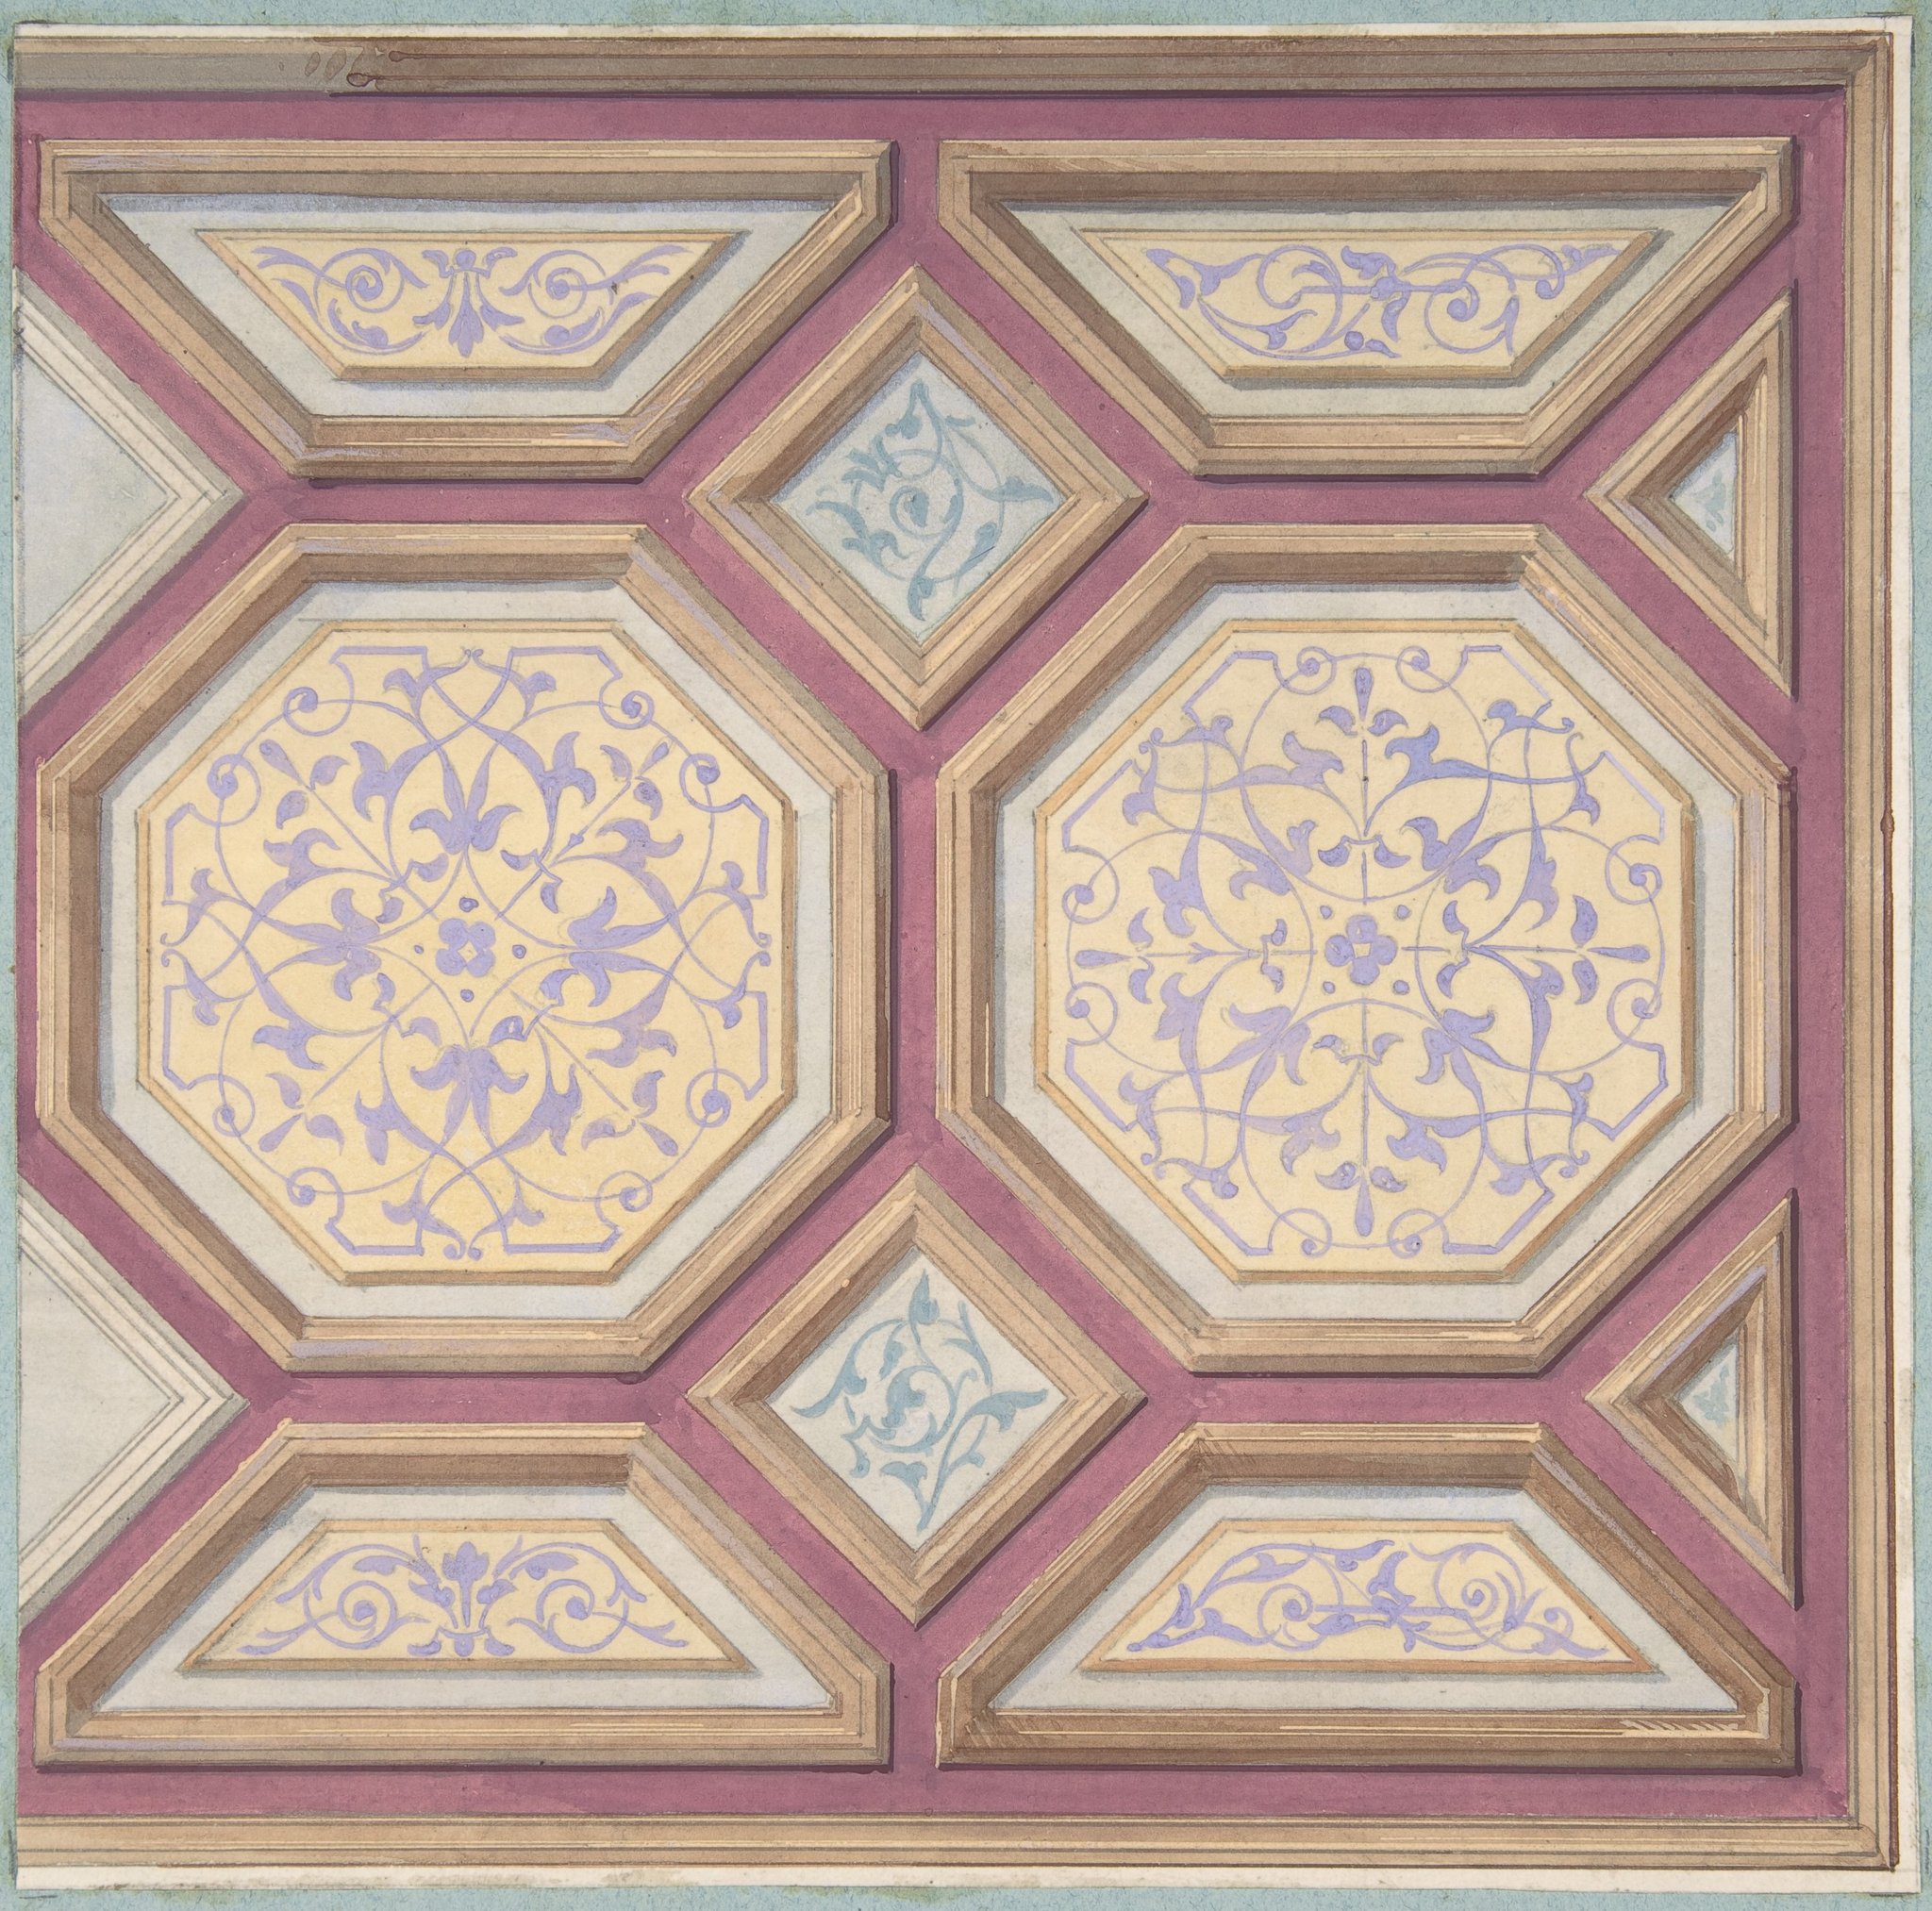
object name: drawing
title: Design for Ceiling, Château de Cangé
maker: jules-edmond-charles lachaise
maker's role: artist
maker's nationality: french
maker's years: 1897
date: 1851-1900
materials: gouache, ink, watercolor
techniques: pen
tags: ceilings